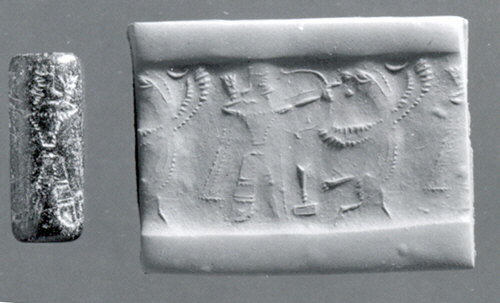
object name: cylinder seal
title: Cylinder seal with mythological contest scene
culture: assyrian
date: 900-701 BCE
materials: stone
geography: northwestern iran